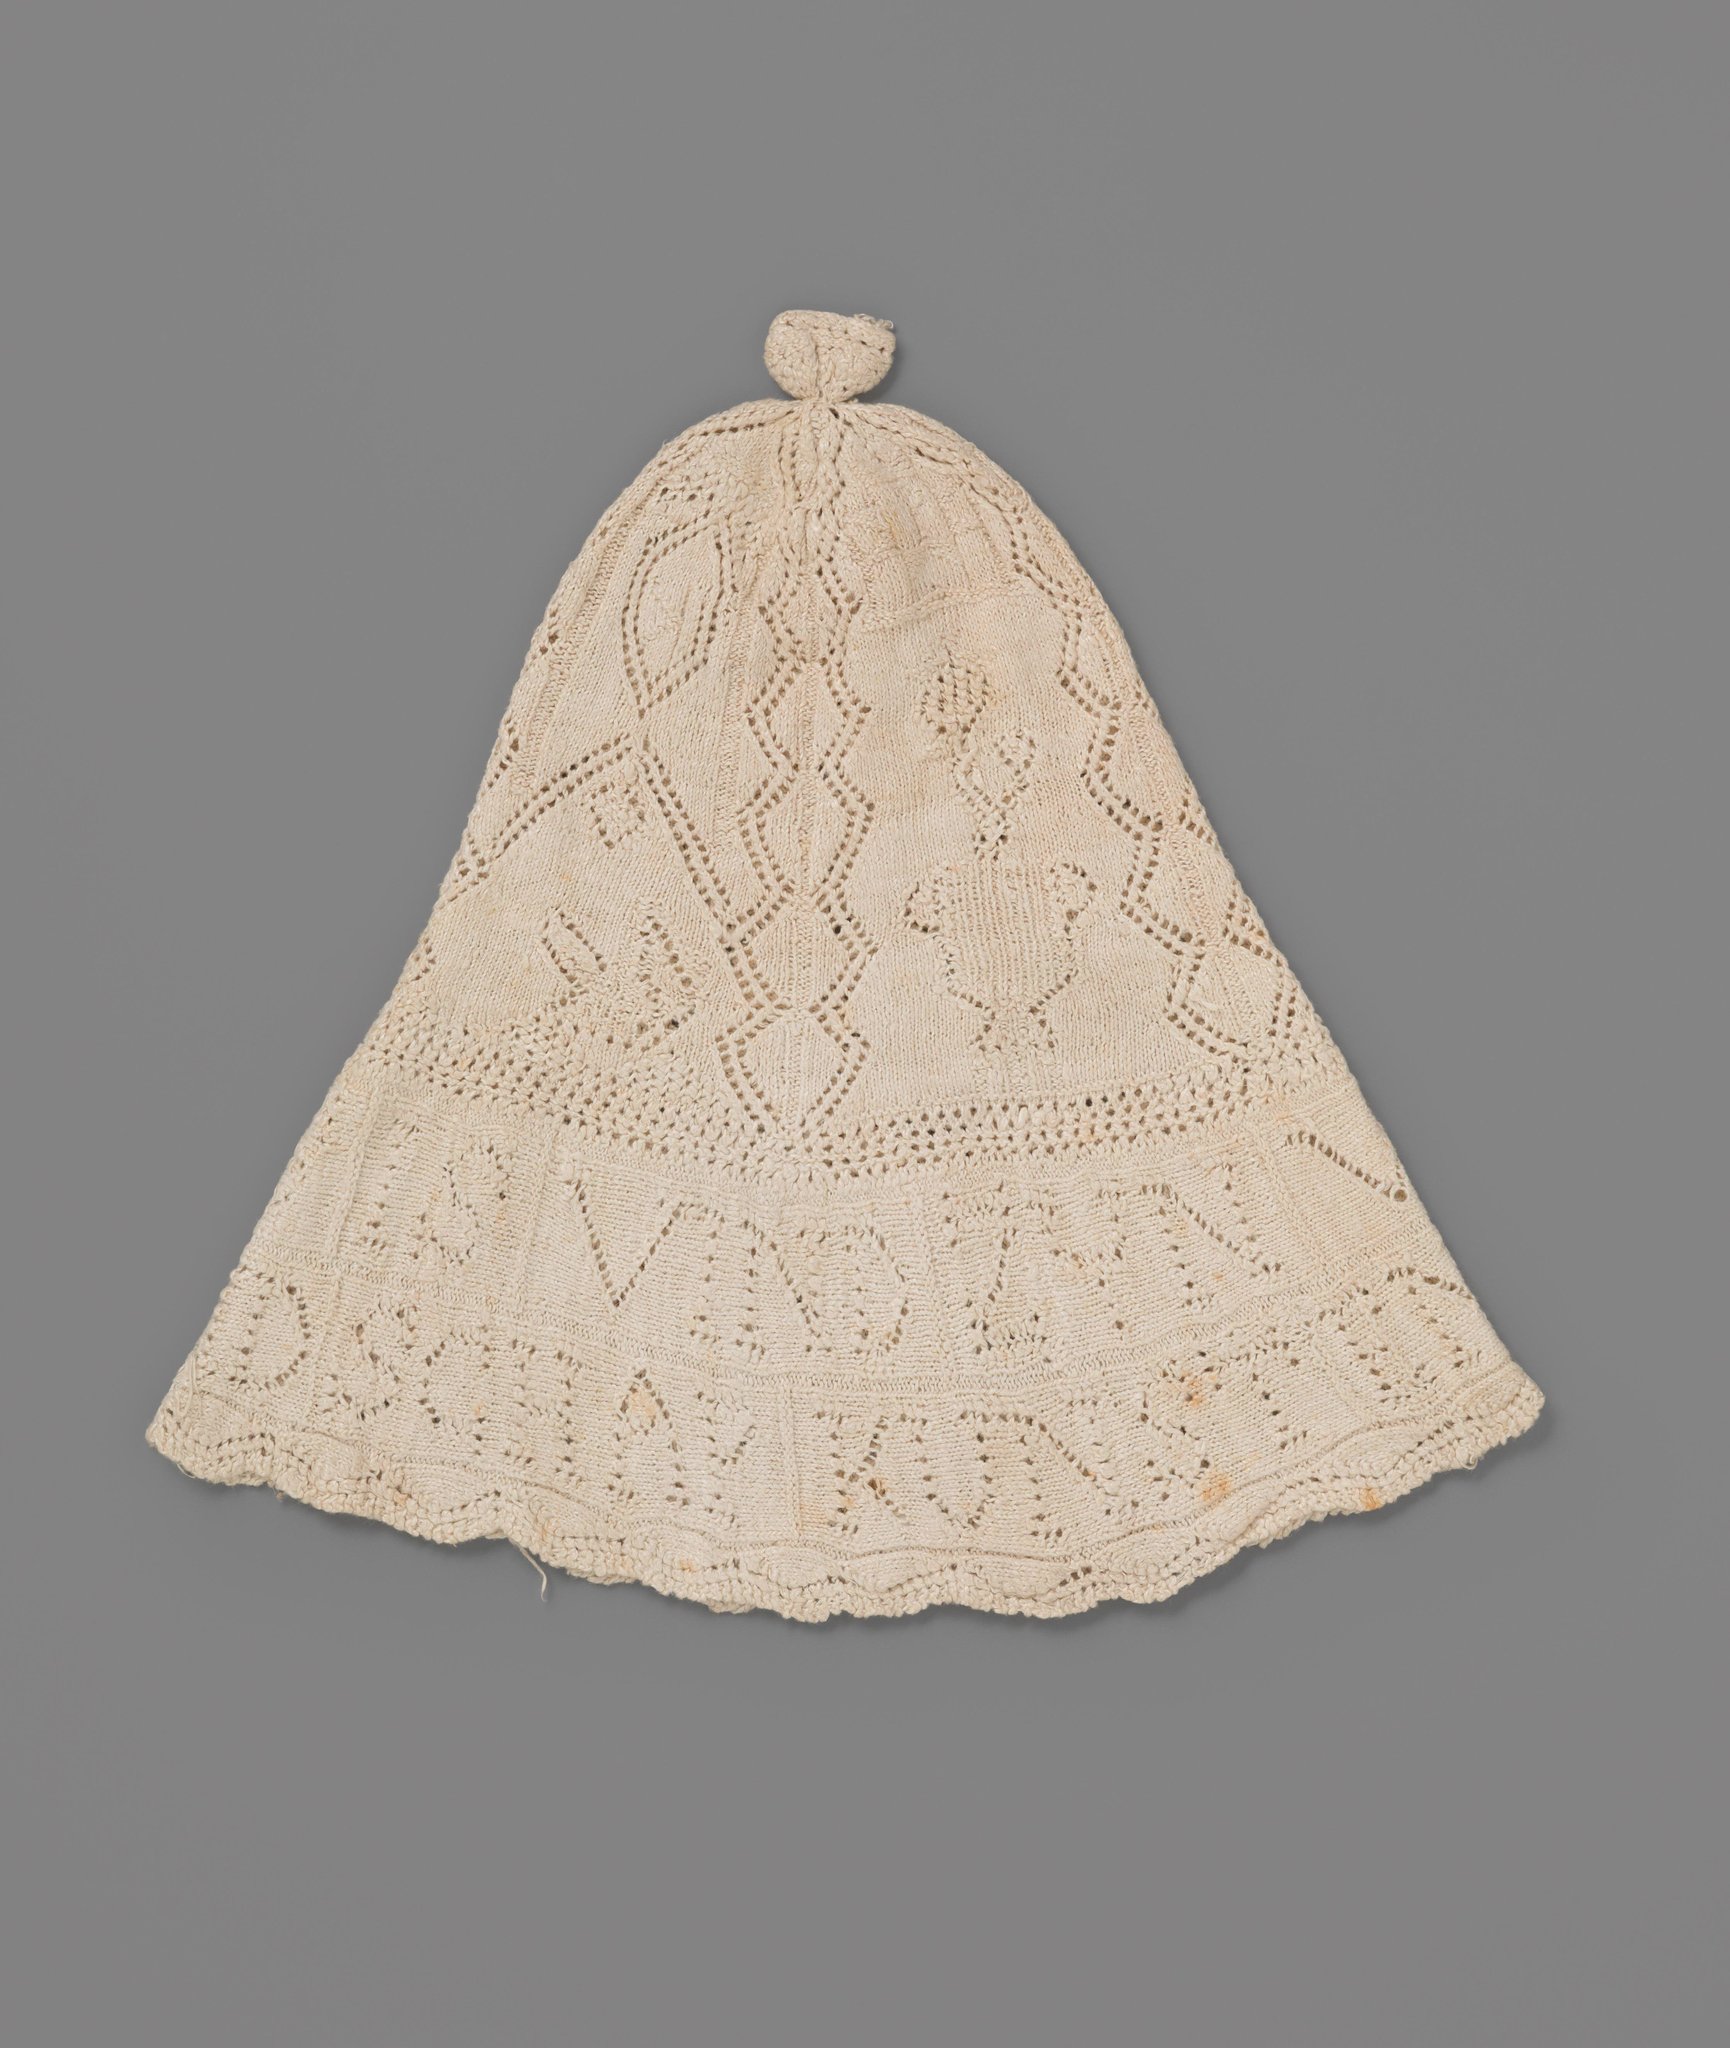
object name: night cap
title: Slaapmuts van gebreide zijde, met ingebreid de tekst: Wie wijs is vind zijn vreugd, In vrienschap, kunst en deugd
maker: Anonymous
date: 1886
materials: silk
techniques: knitting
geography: netherlands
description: Slaapmuts van gebreide zijde, in tricotsteek met ajourpatroon. Met ingebreid de tekst: 'Wie wijs is vind zijn vreugd, In vrienschap, kunst en deugd'.